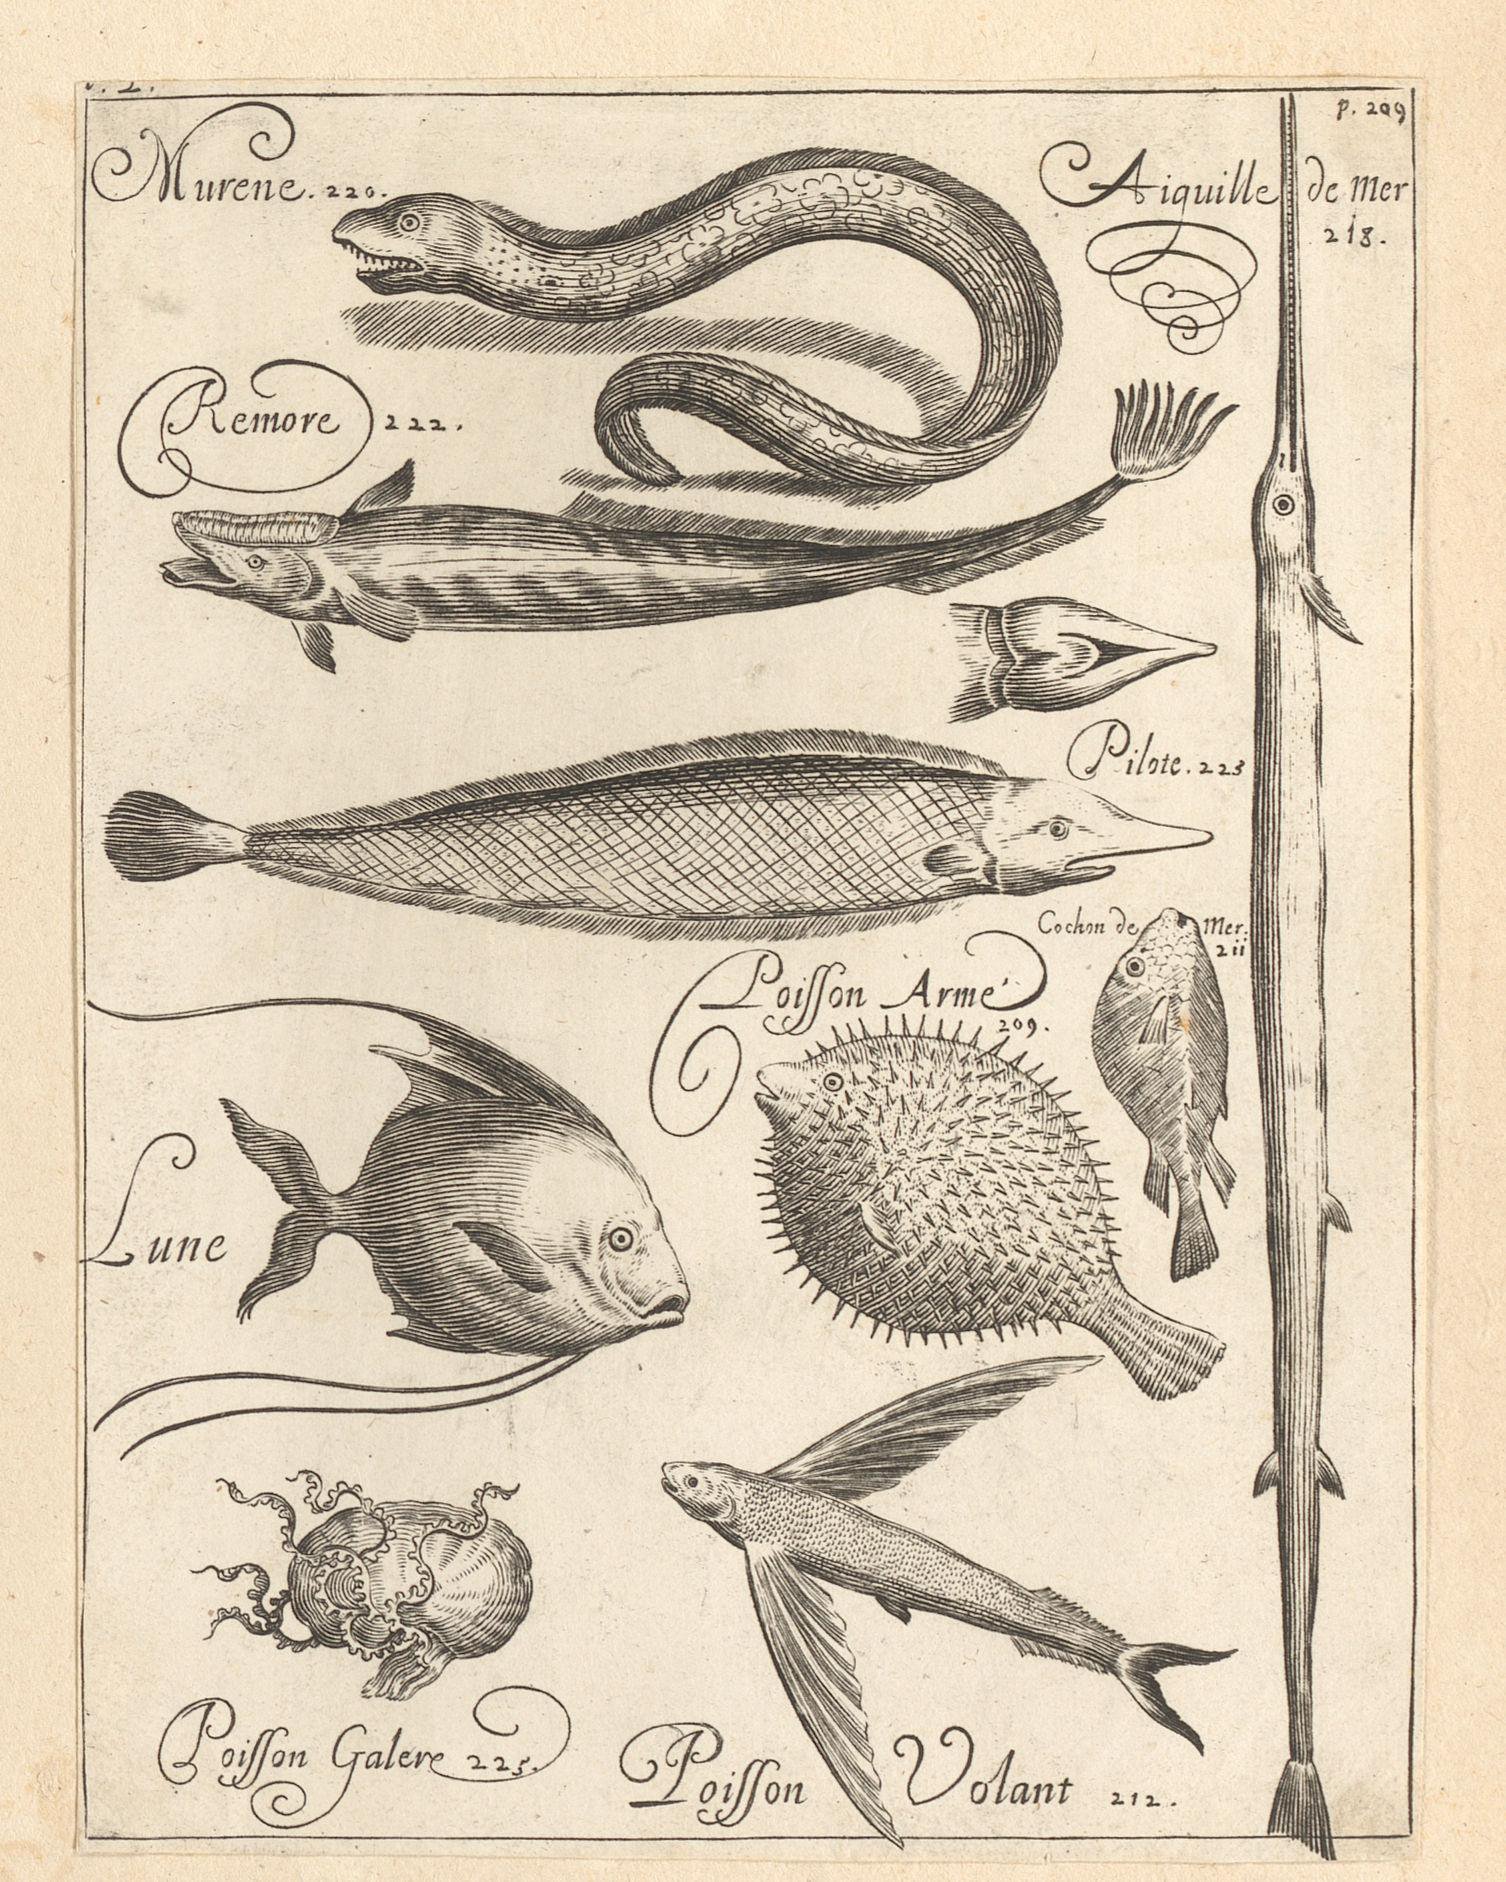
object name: book illustration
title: Verschillende vissoorten van de Franse Antillen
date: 1667-1671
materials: paper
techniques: etching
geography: paris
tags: eels, fishes, bony fishes: blowfish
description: Verschillende inheemse vissoorten, allen vergezeld door de naam van de vis op de plaat. Genummerd rechtsboven: p. 209. Prent maakt deel uit van een album.